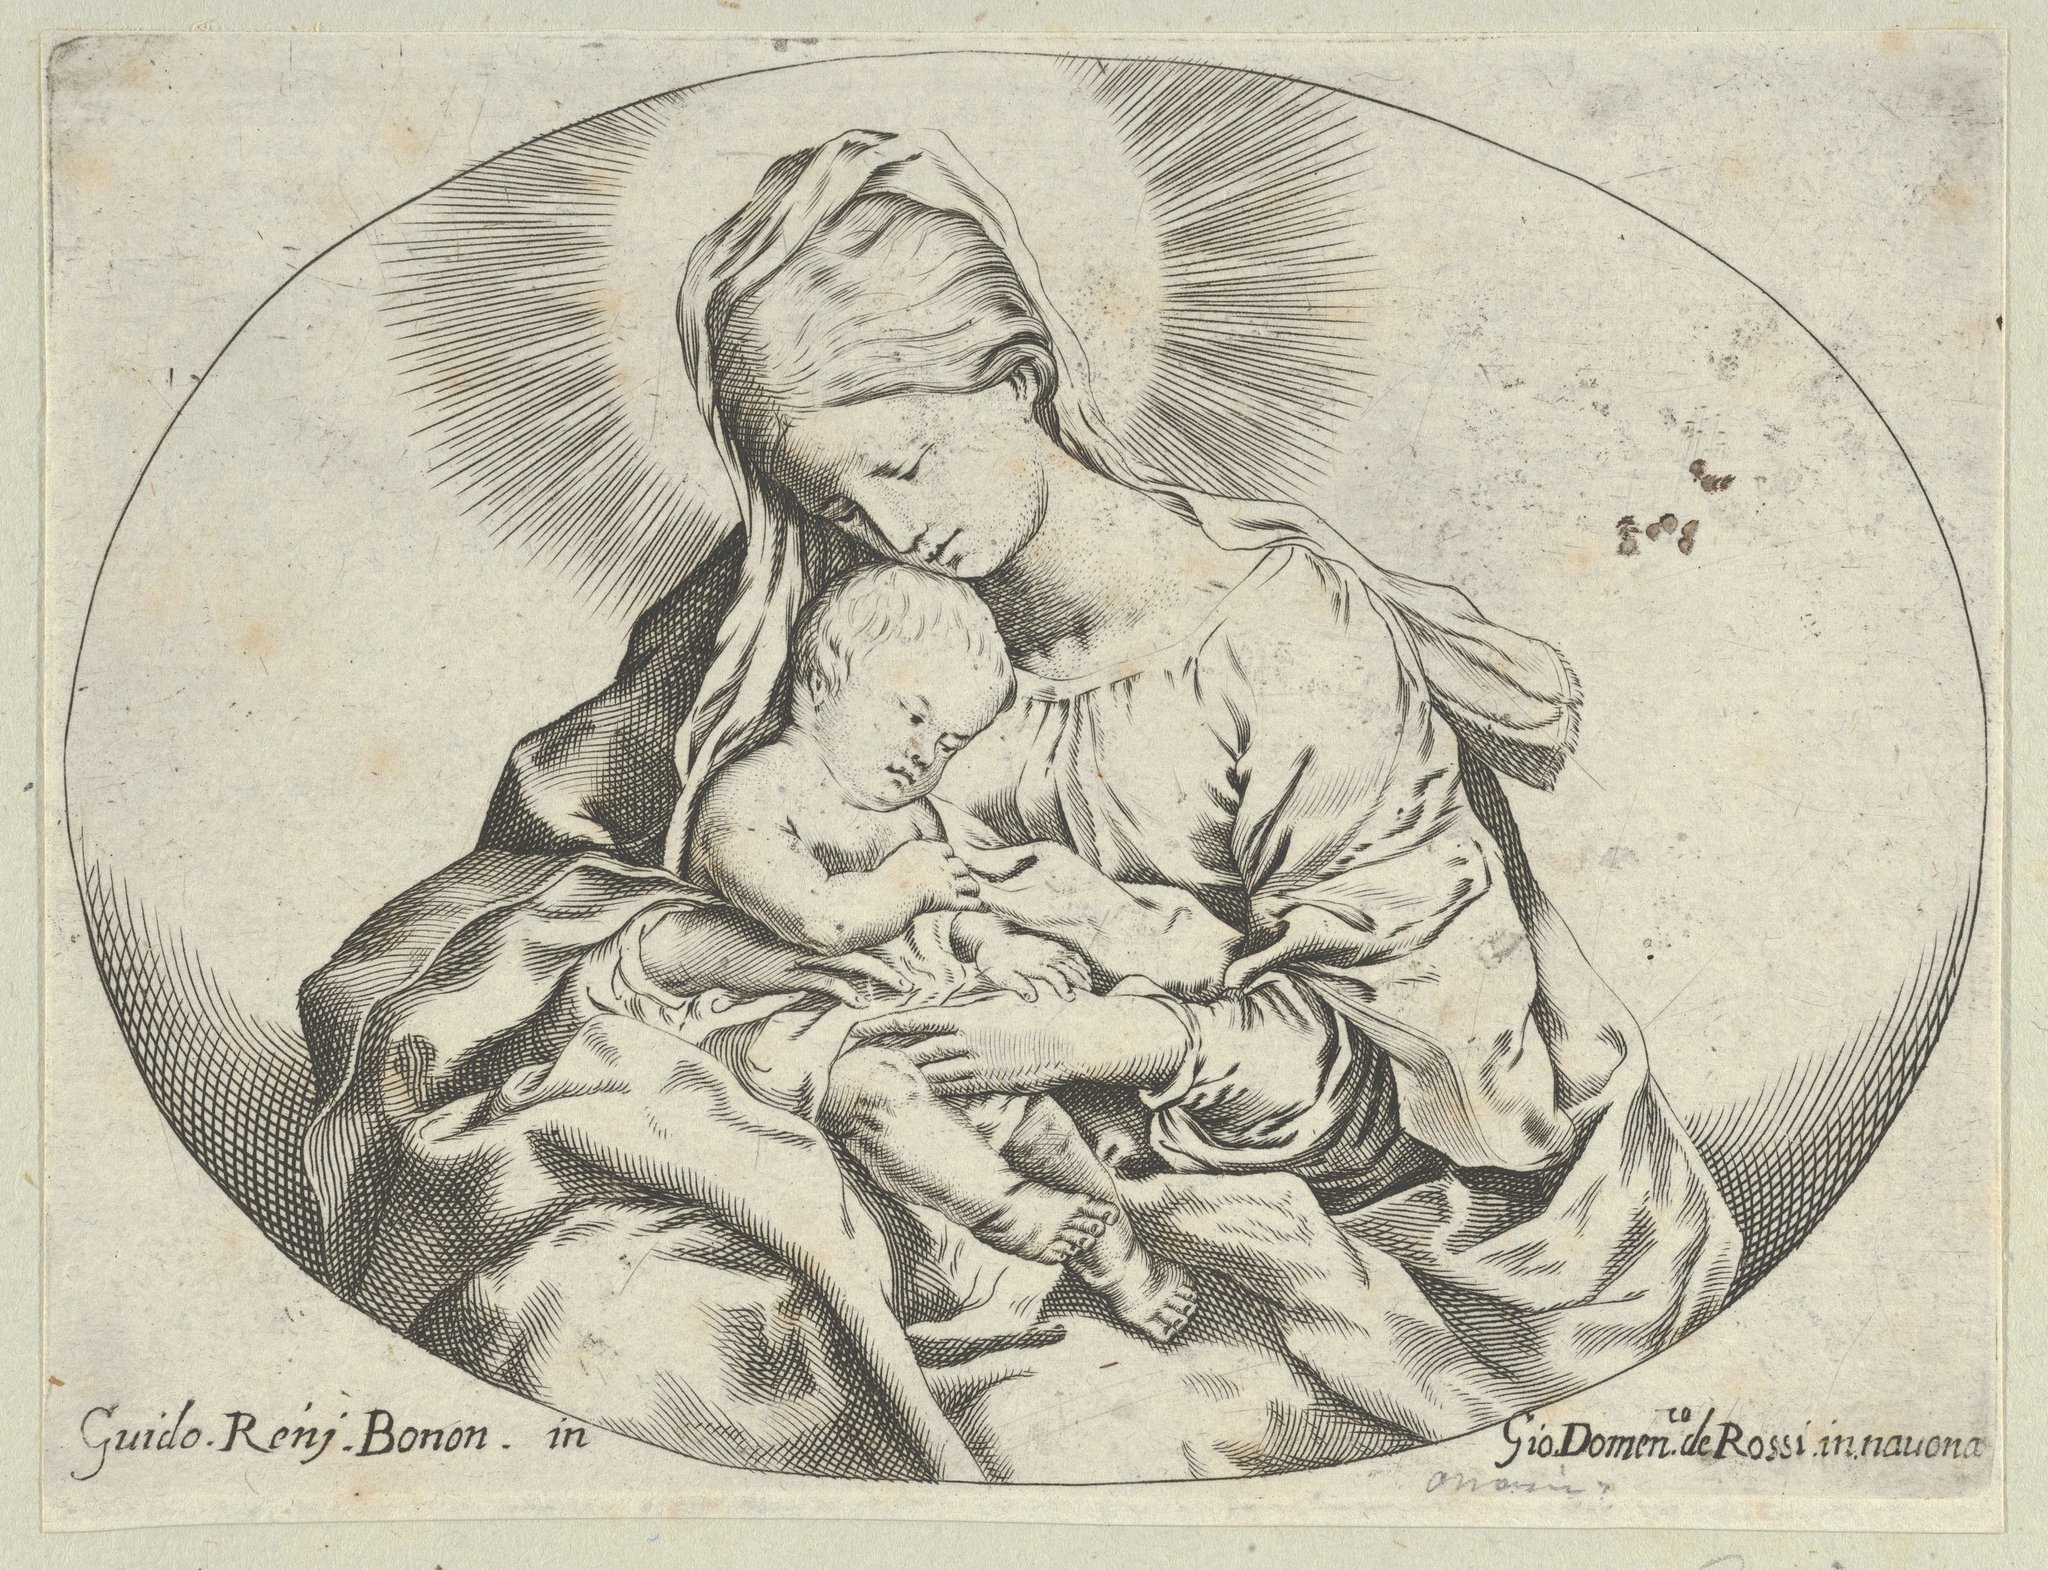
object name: print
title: The Virgin holding the infant Christ, an oval composition, after Reni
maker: anonymous, 17th century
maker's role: artist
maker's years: 1600-1700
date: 1600-1640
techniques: etching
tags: madonna and child